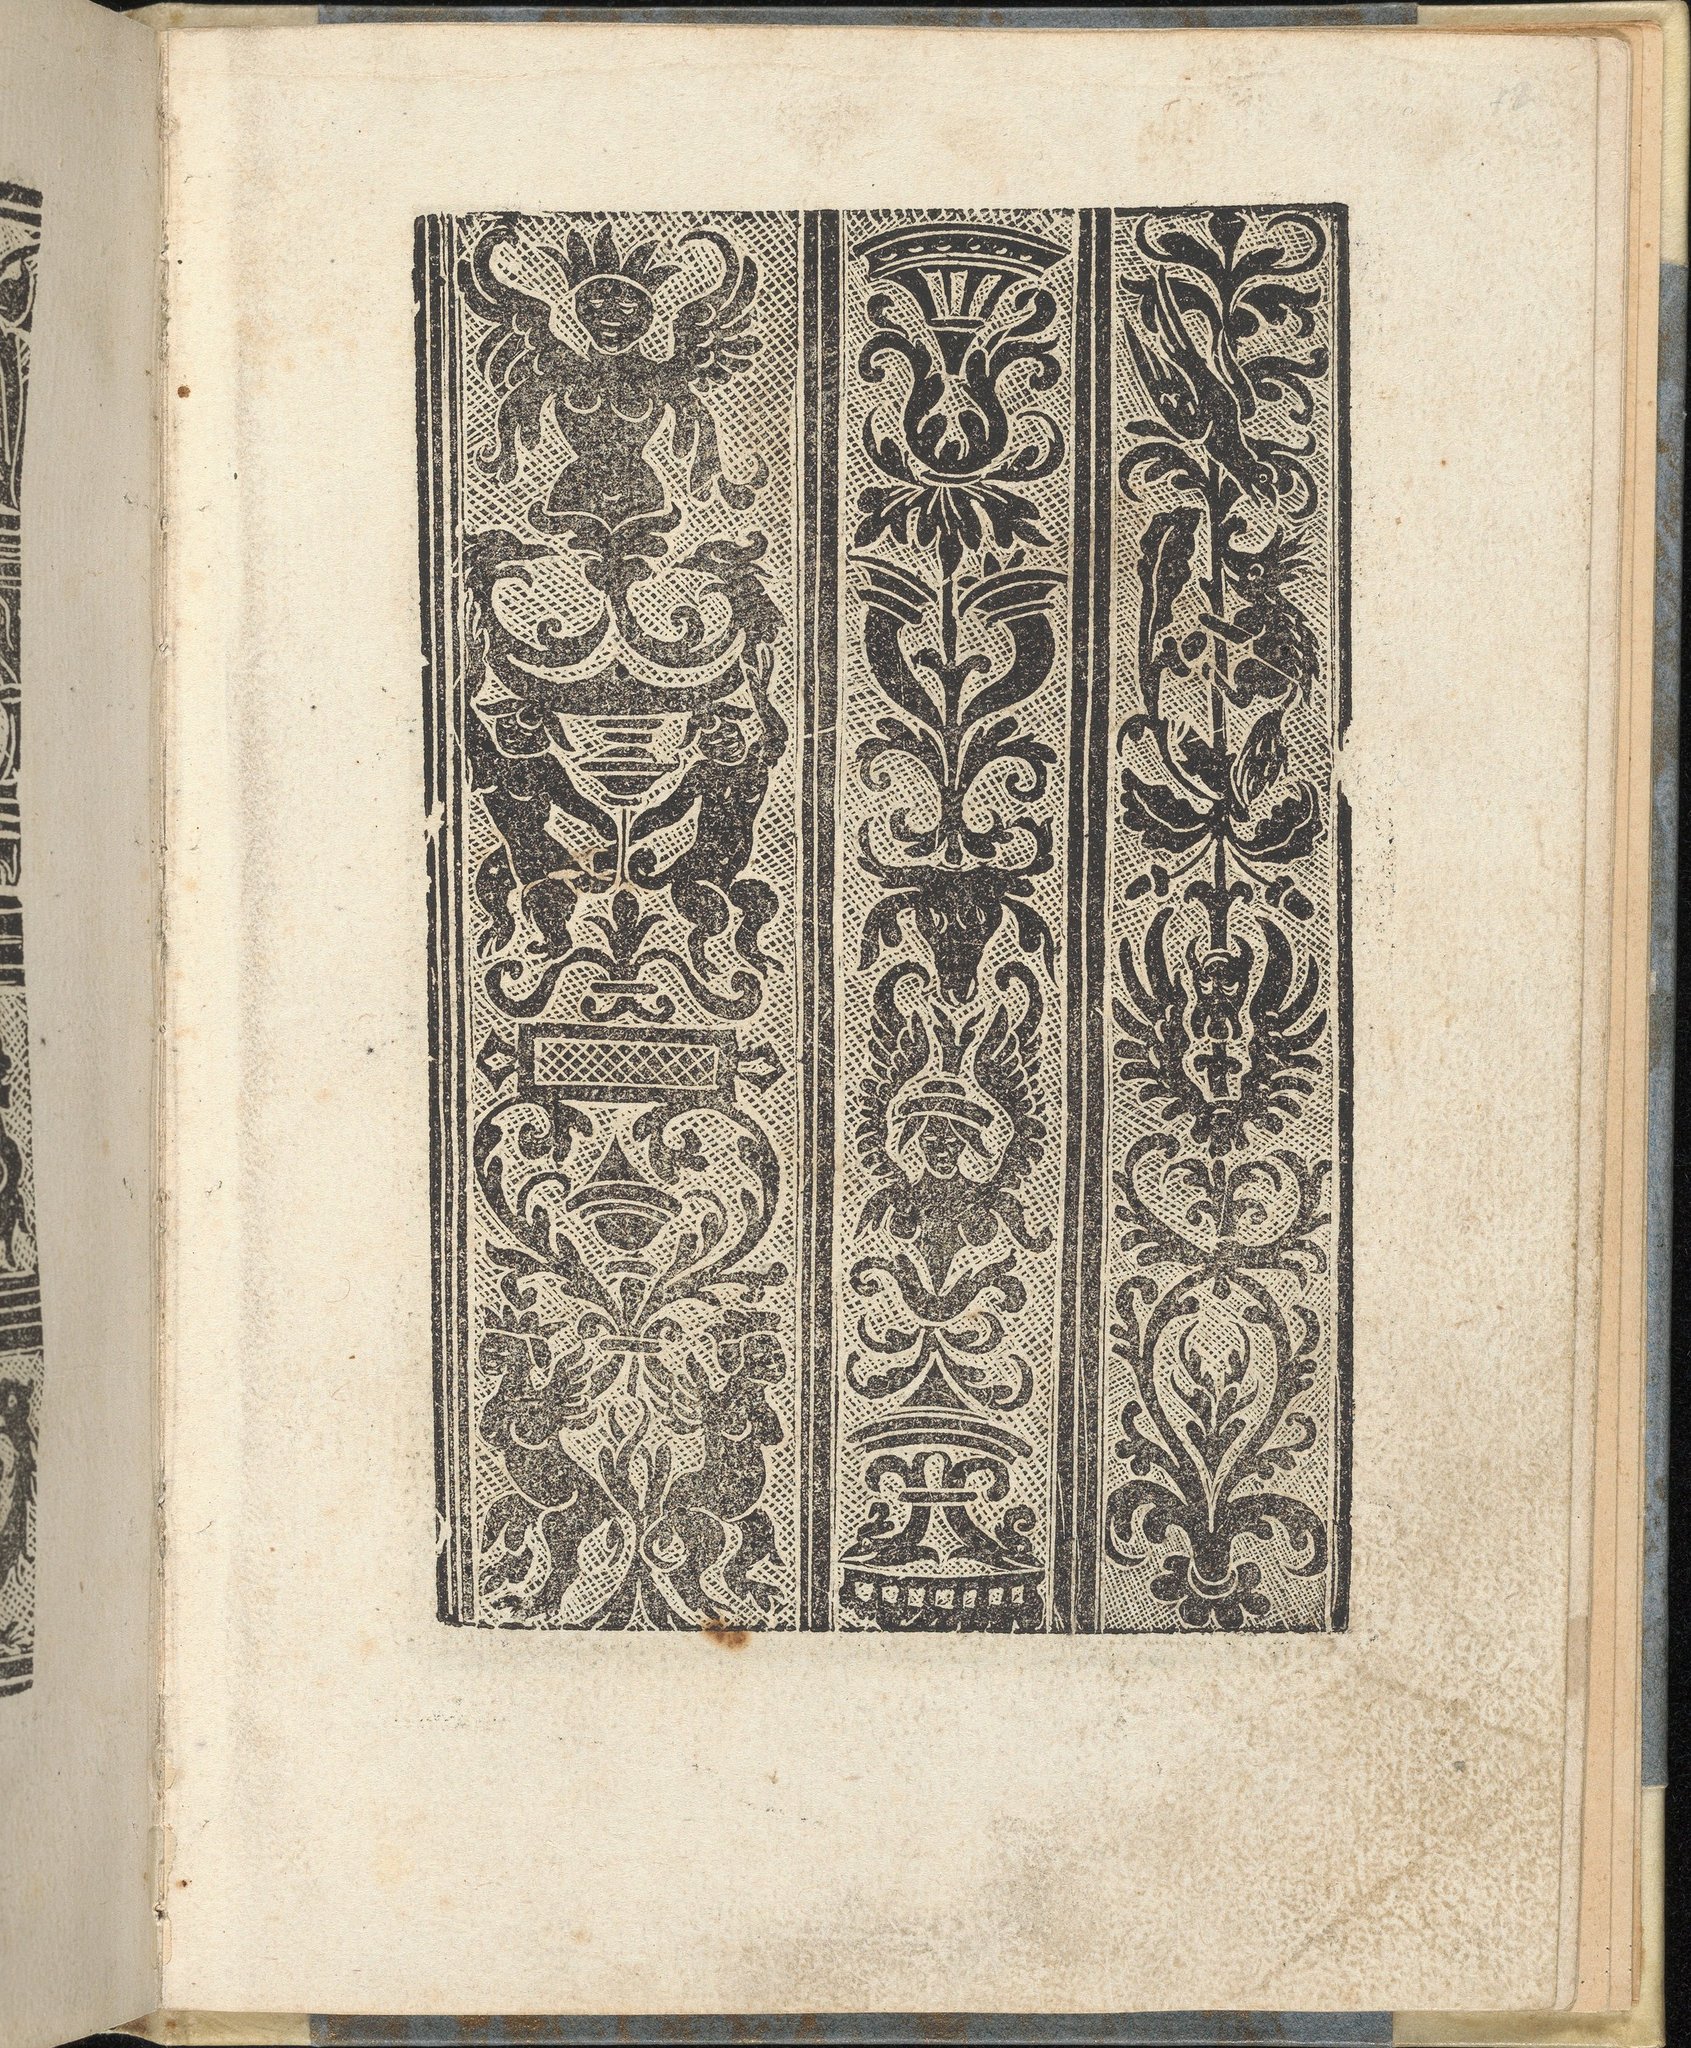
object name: book print ornament architecture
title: Ein ney Furmbüchlein, Page 12, recto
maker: johann schönsperger the younger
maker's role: publisher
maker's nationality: german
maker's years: 1490-1550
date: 1525-1529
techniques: woodcut